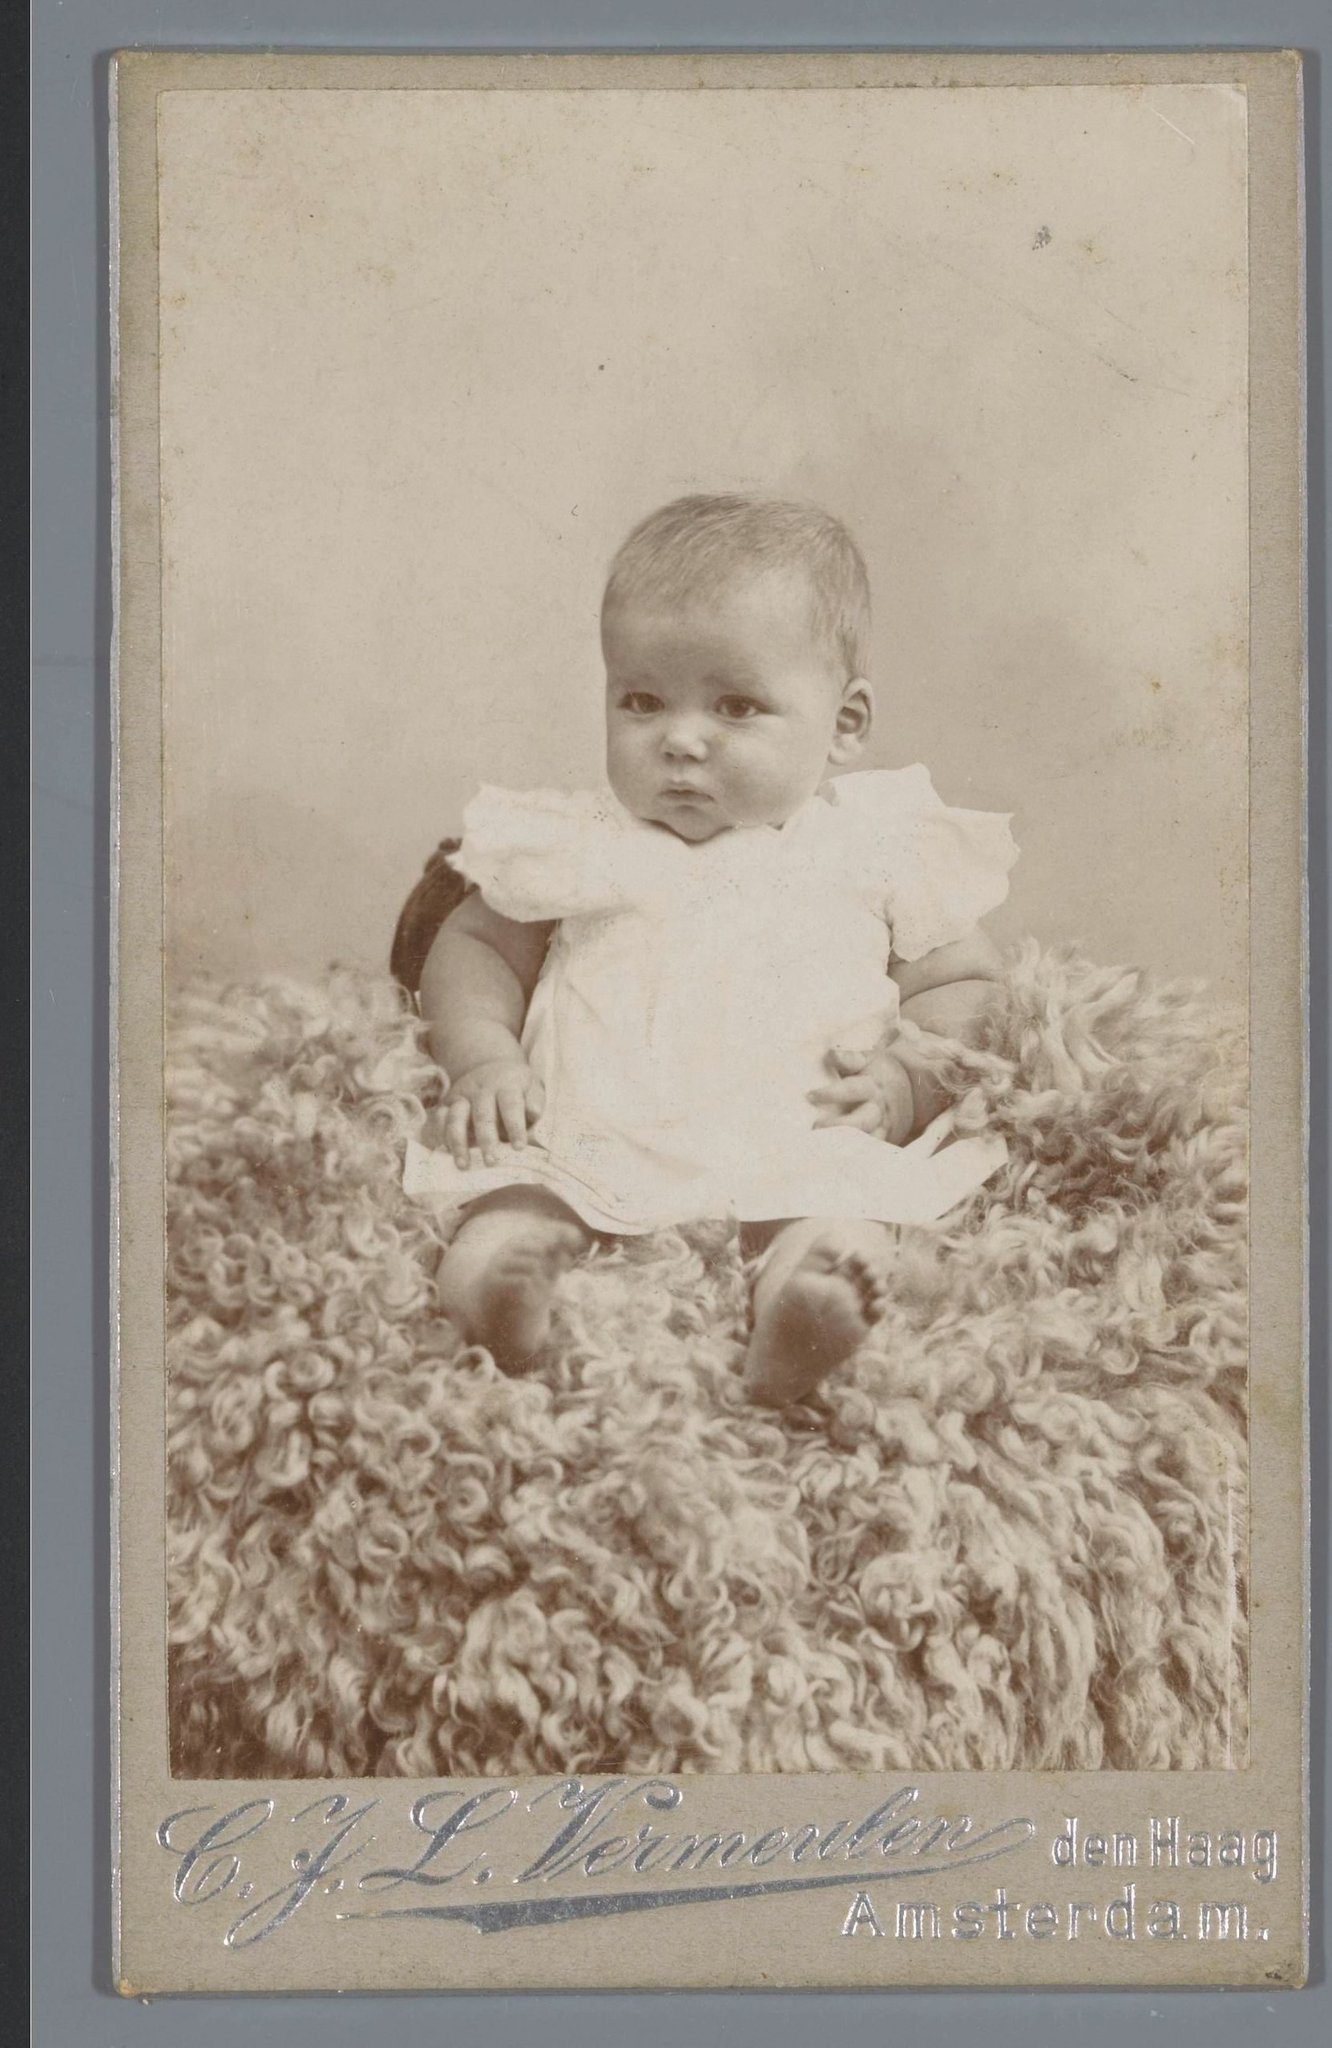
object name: photograph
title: Portret van een onbekende baby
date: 1890-1915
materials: cardboard, photographic support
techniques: collodion silver print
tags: historical persons, infant, baby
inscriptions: inscription: ‘C. J. L. Vermeulen,/ Heiligenweg hoek Singel/ Heerenstraat 6./ Telephoon No. 2339 en 2340./ Amsterdam./ Toussaintkade 11/ den Haag./ Intercommunal Telephoon: 774.’